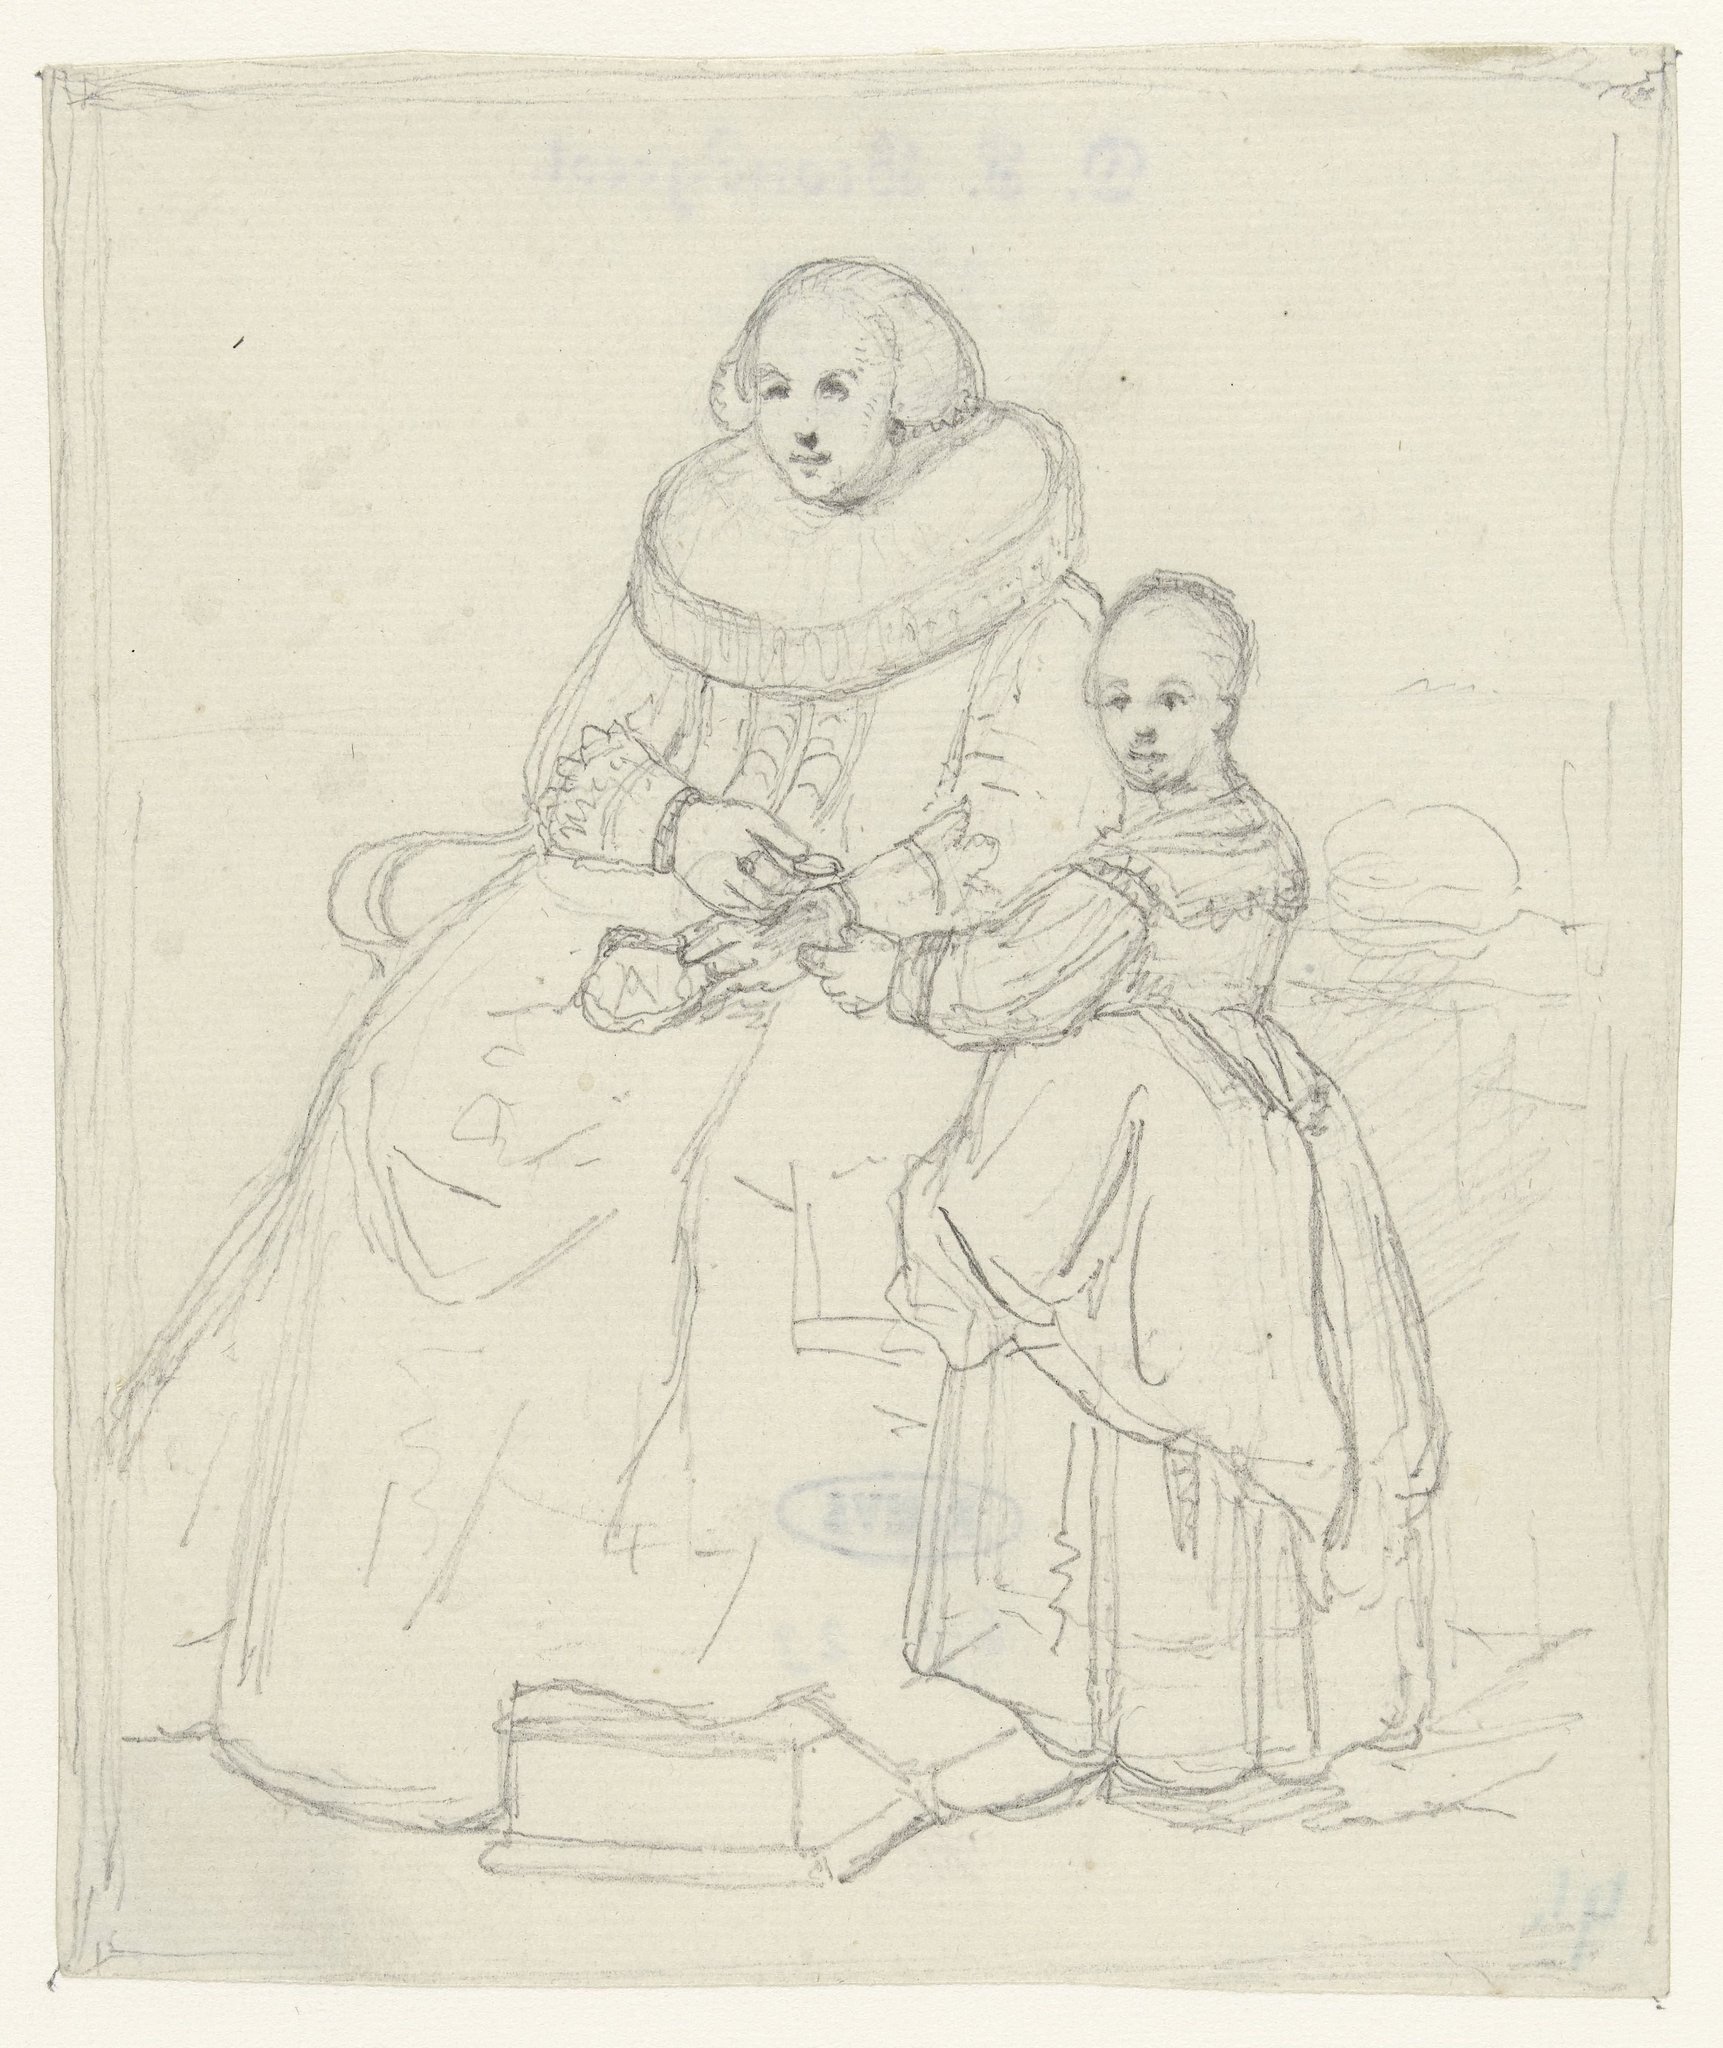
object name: drawing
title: Portret van Susanna van Collen, echtgenote van Jean Pellicorne, met haar dochter Anna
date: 1796-1849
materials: paper, pencil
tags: anonymous historical person portrayed alone, mother and baby or young child, mother and daughter(s) (family group)